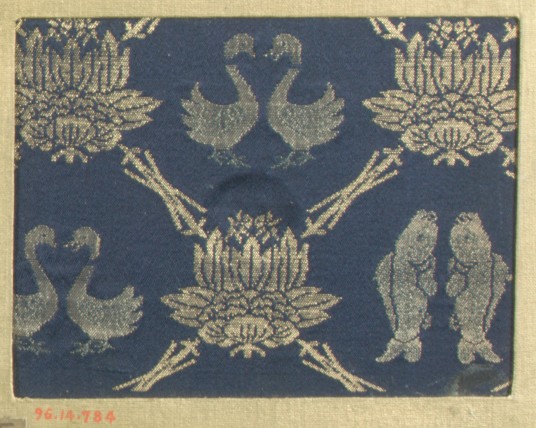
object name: piece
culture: japanese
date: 1701-1900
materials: silk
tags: fish,flowers